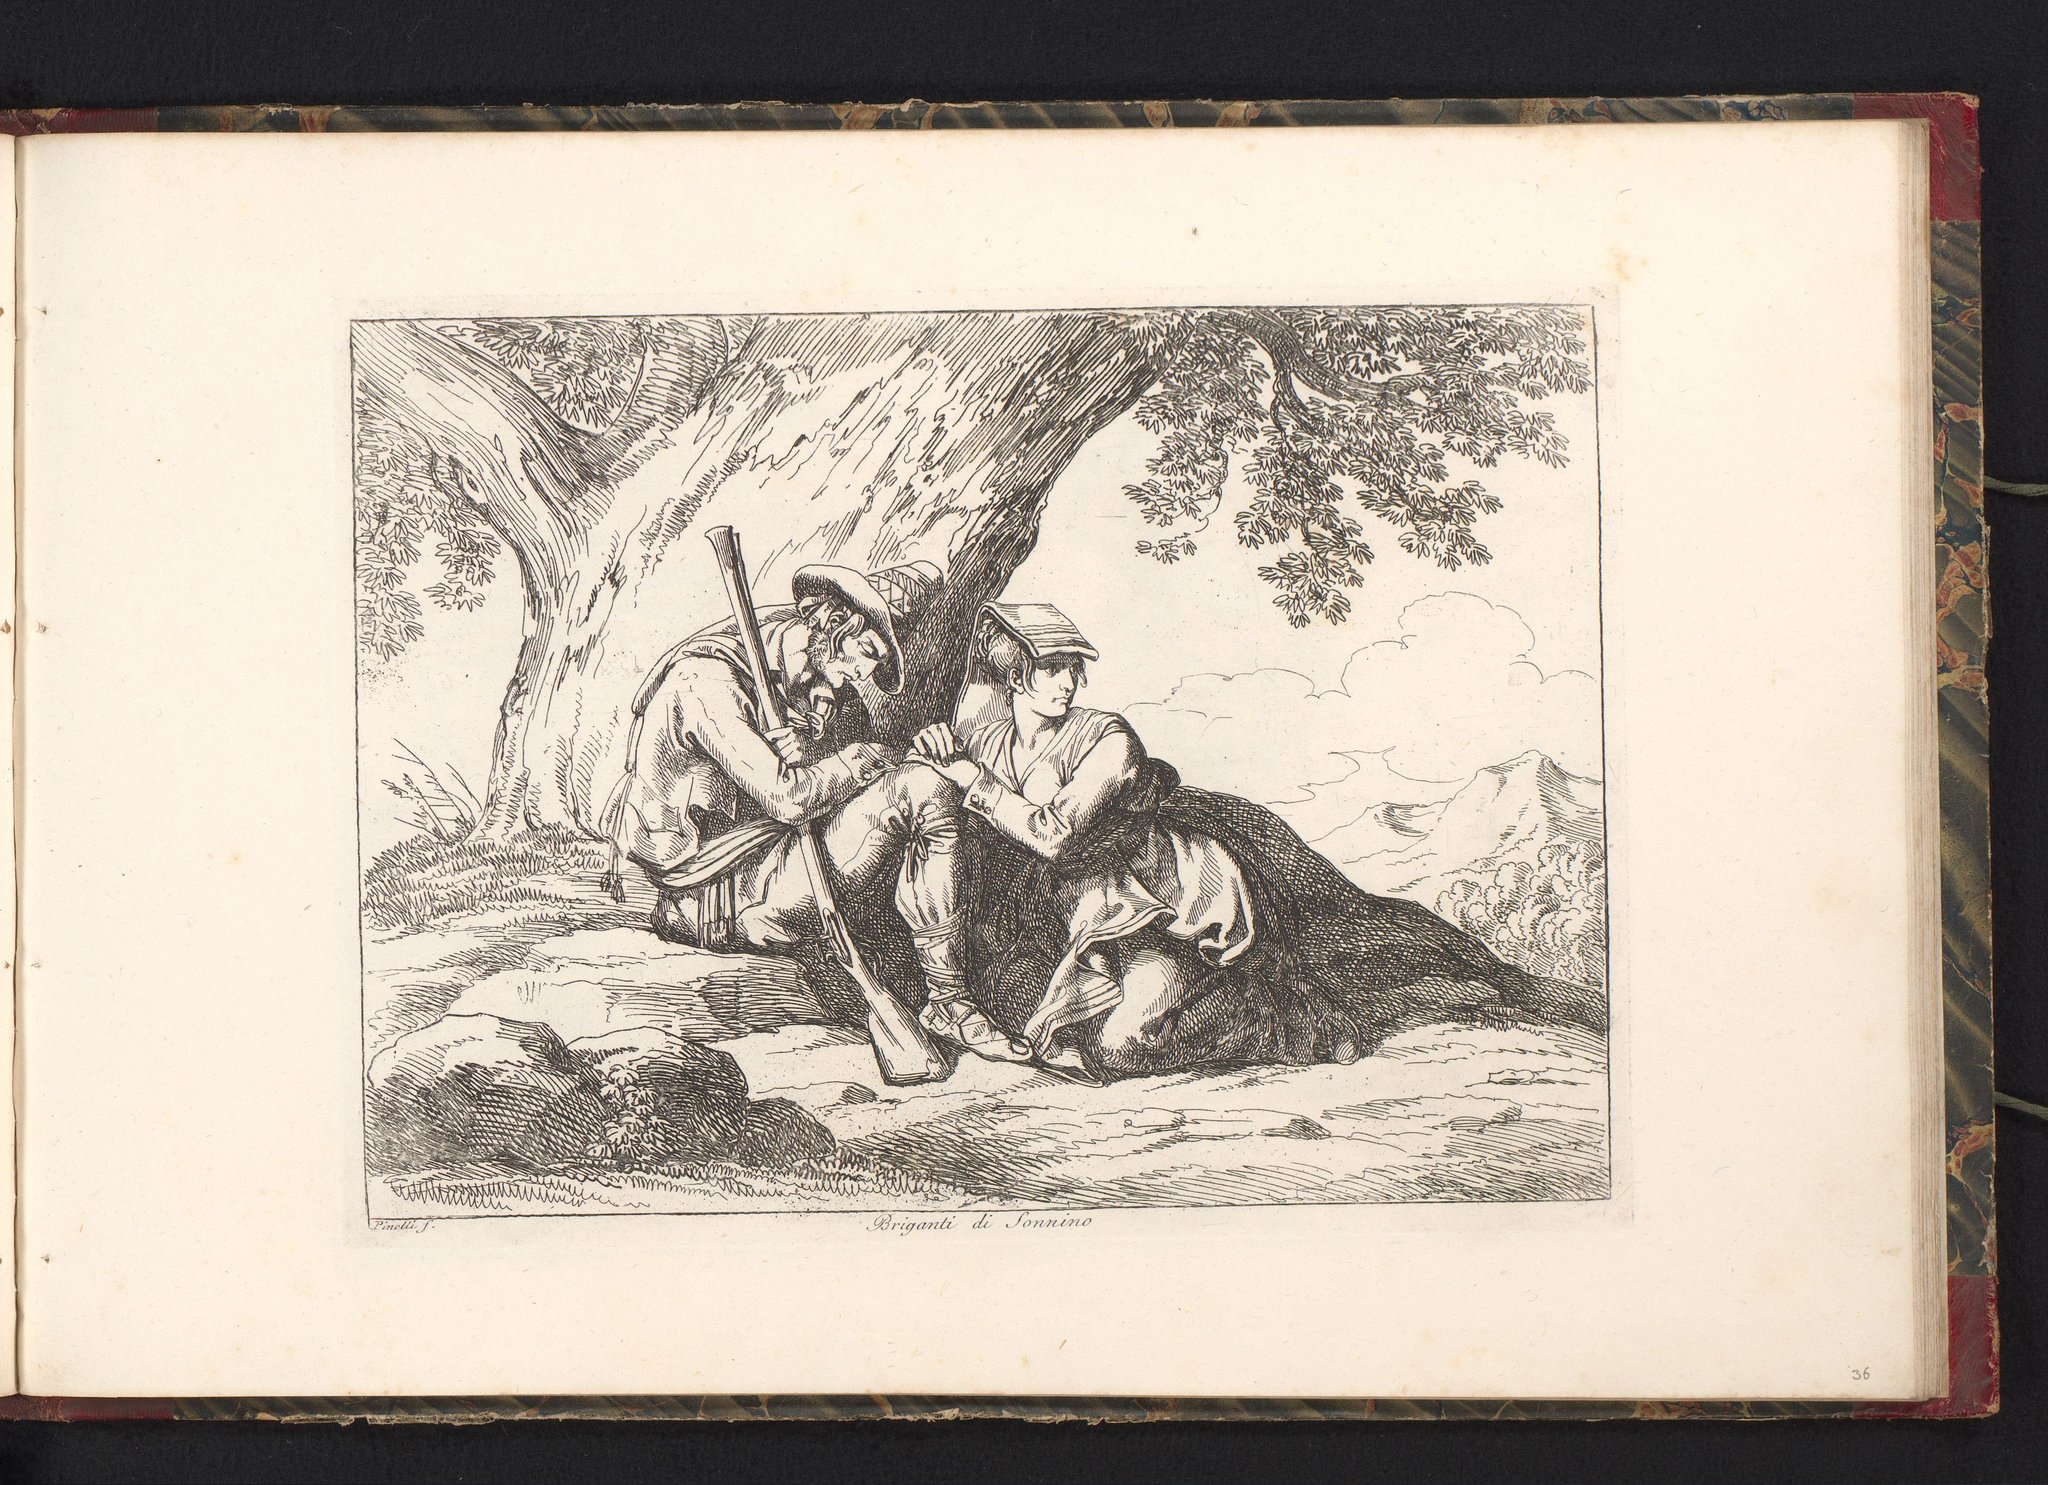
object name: print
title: Nuova raccolta di cinquanta costumi de contorni di Roma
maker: bartolomeo pinelli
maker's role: draughtsman, print maker, sculptor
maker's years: 1781-1835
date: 1819-1823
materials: paper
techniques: etching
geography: rome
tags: robber, (traveller) resting in the open air, folk costume, regional costume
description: Een vrouw en een man met een geweer, rustend aan de voet van een boom in een landschap. De prent maakt deel uit van een album.